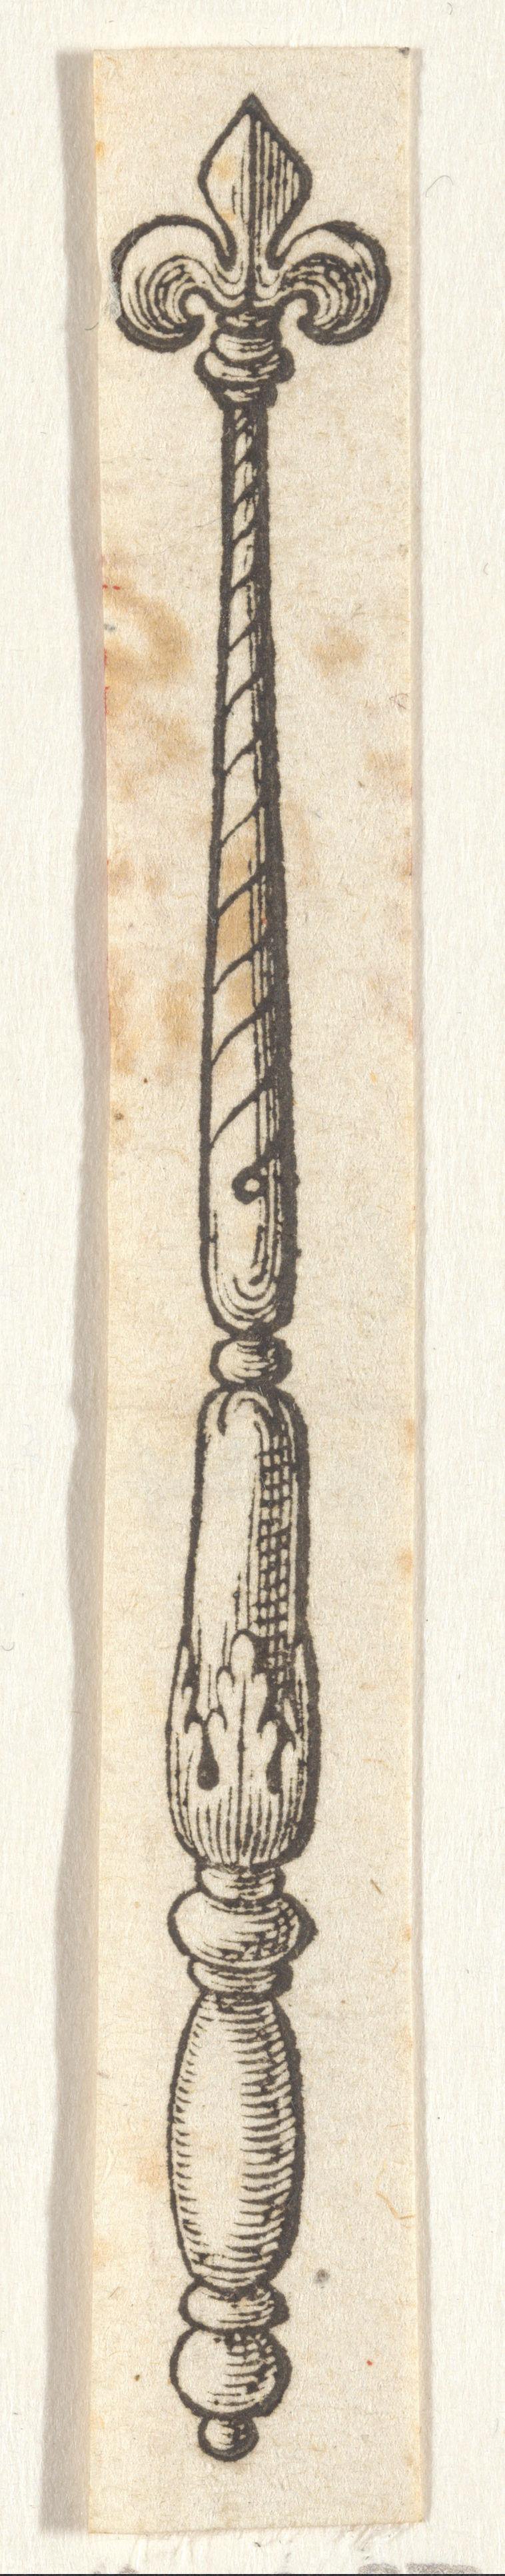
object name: print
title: Vignet met een scepter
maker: Anonymous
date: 1600-1699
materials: paper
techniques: woodcut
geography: netherlands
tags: vignette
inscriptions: collector's mark: Lugt 240